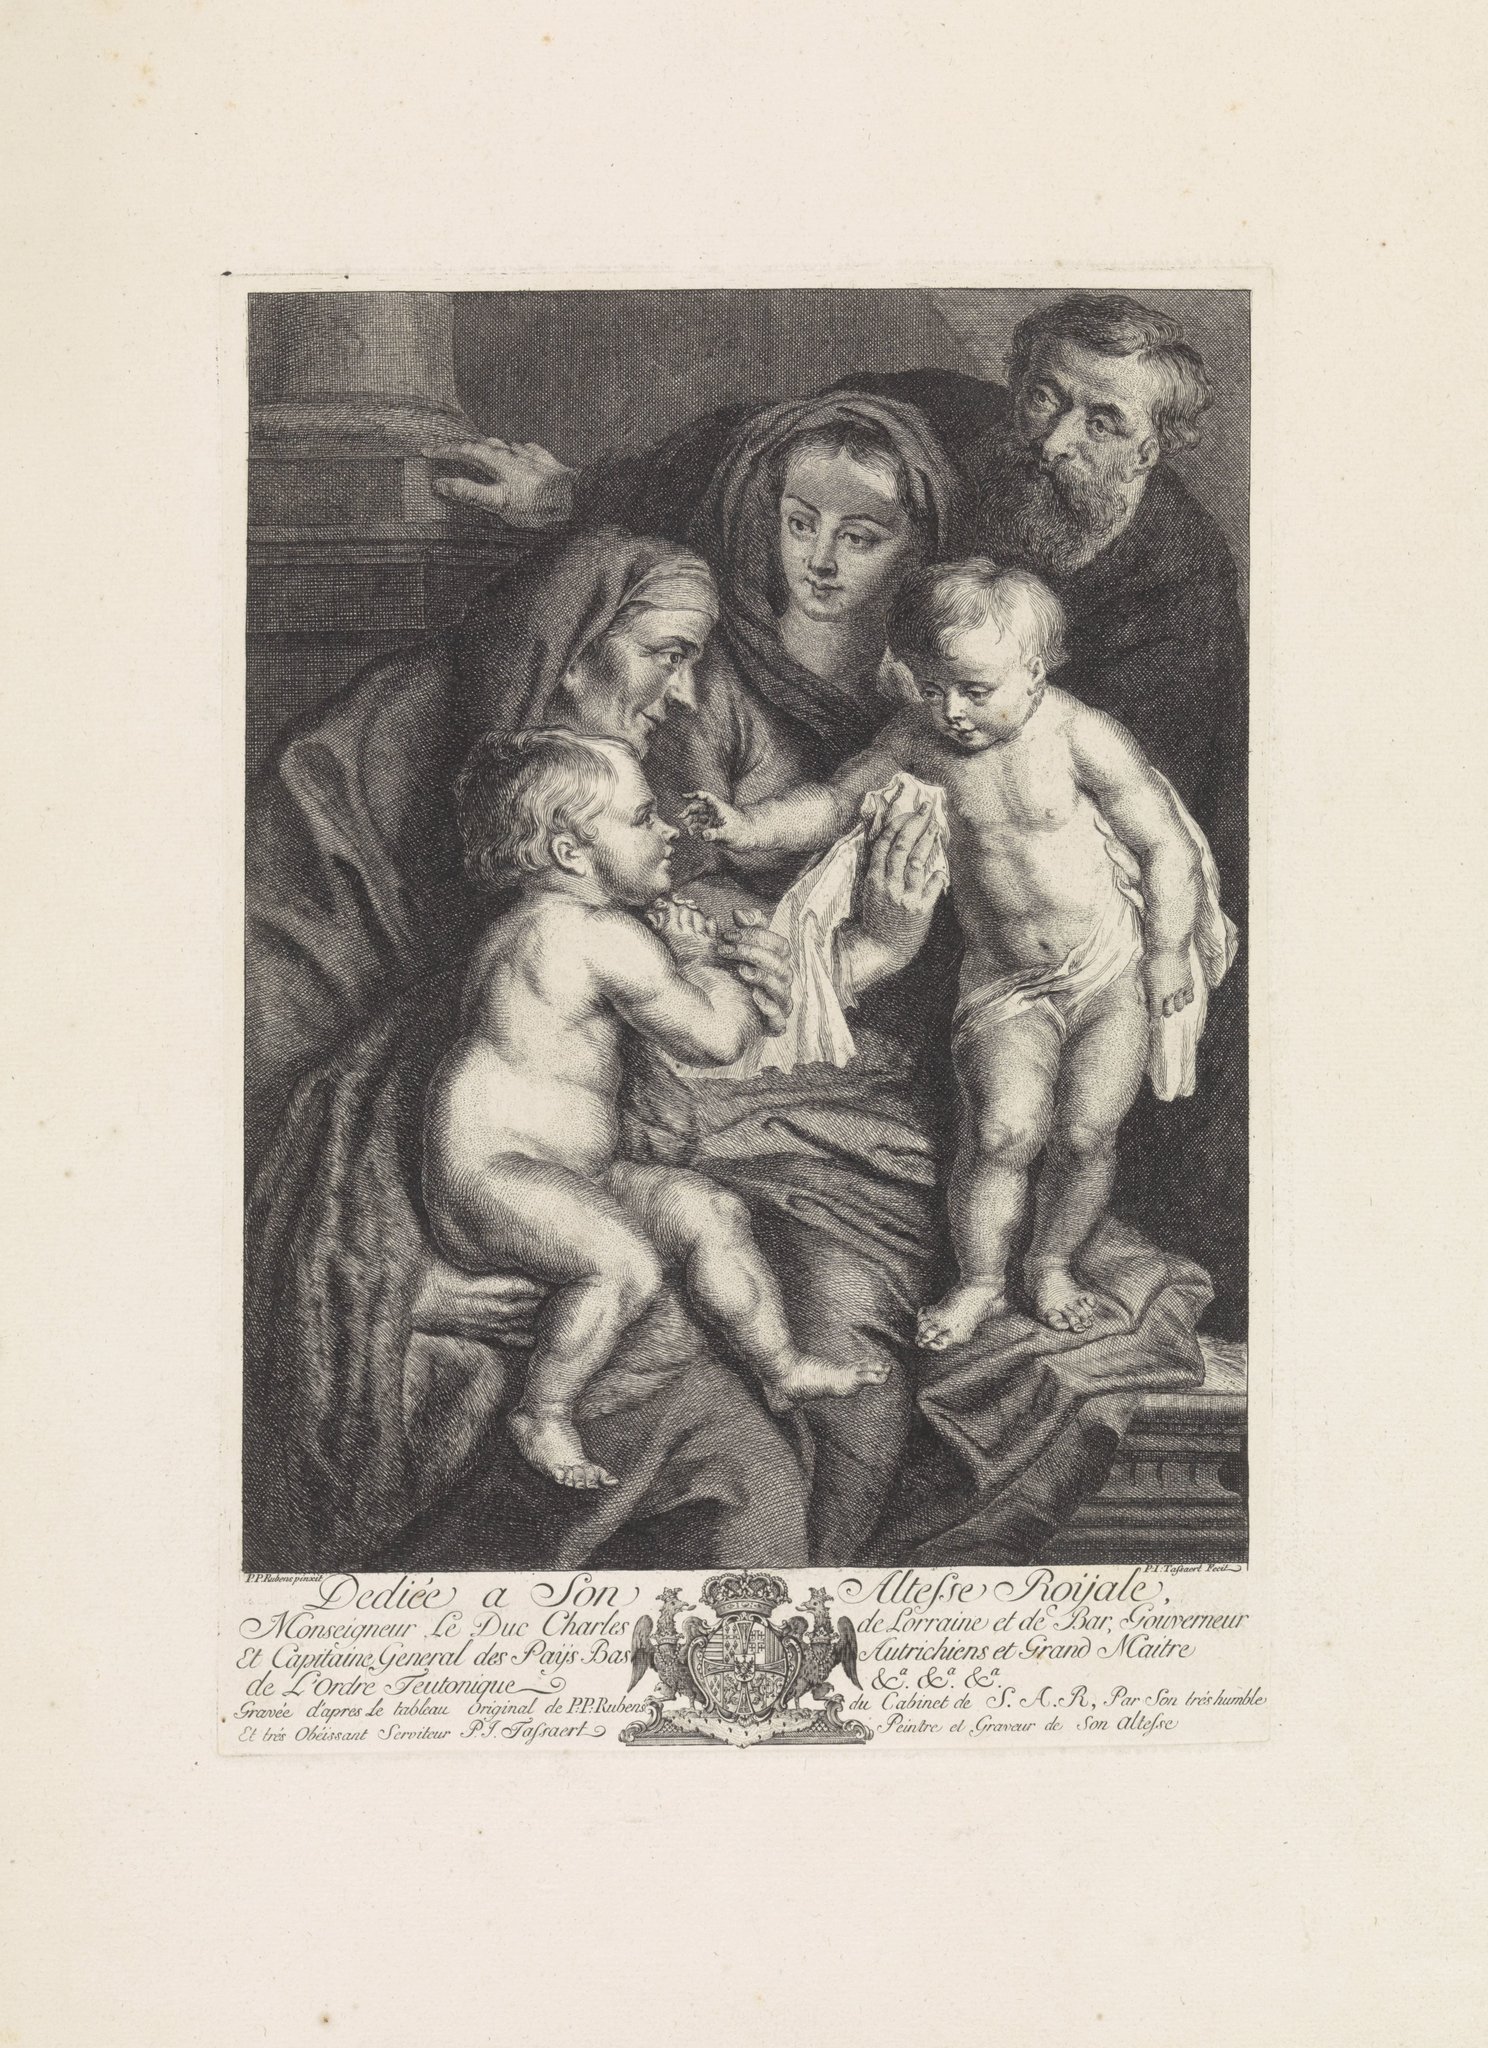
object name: print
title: Heilige Familie met Elisabeth en Johannes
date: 1744-1803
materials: paper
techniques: etching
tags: holy family with john the baptist, elisabeth present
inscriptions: collector's mark: Lugt 240